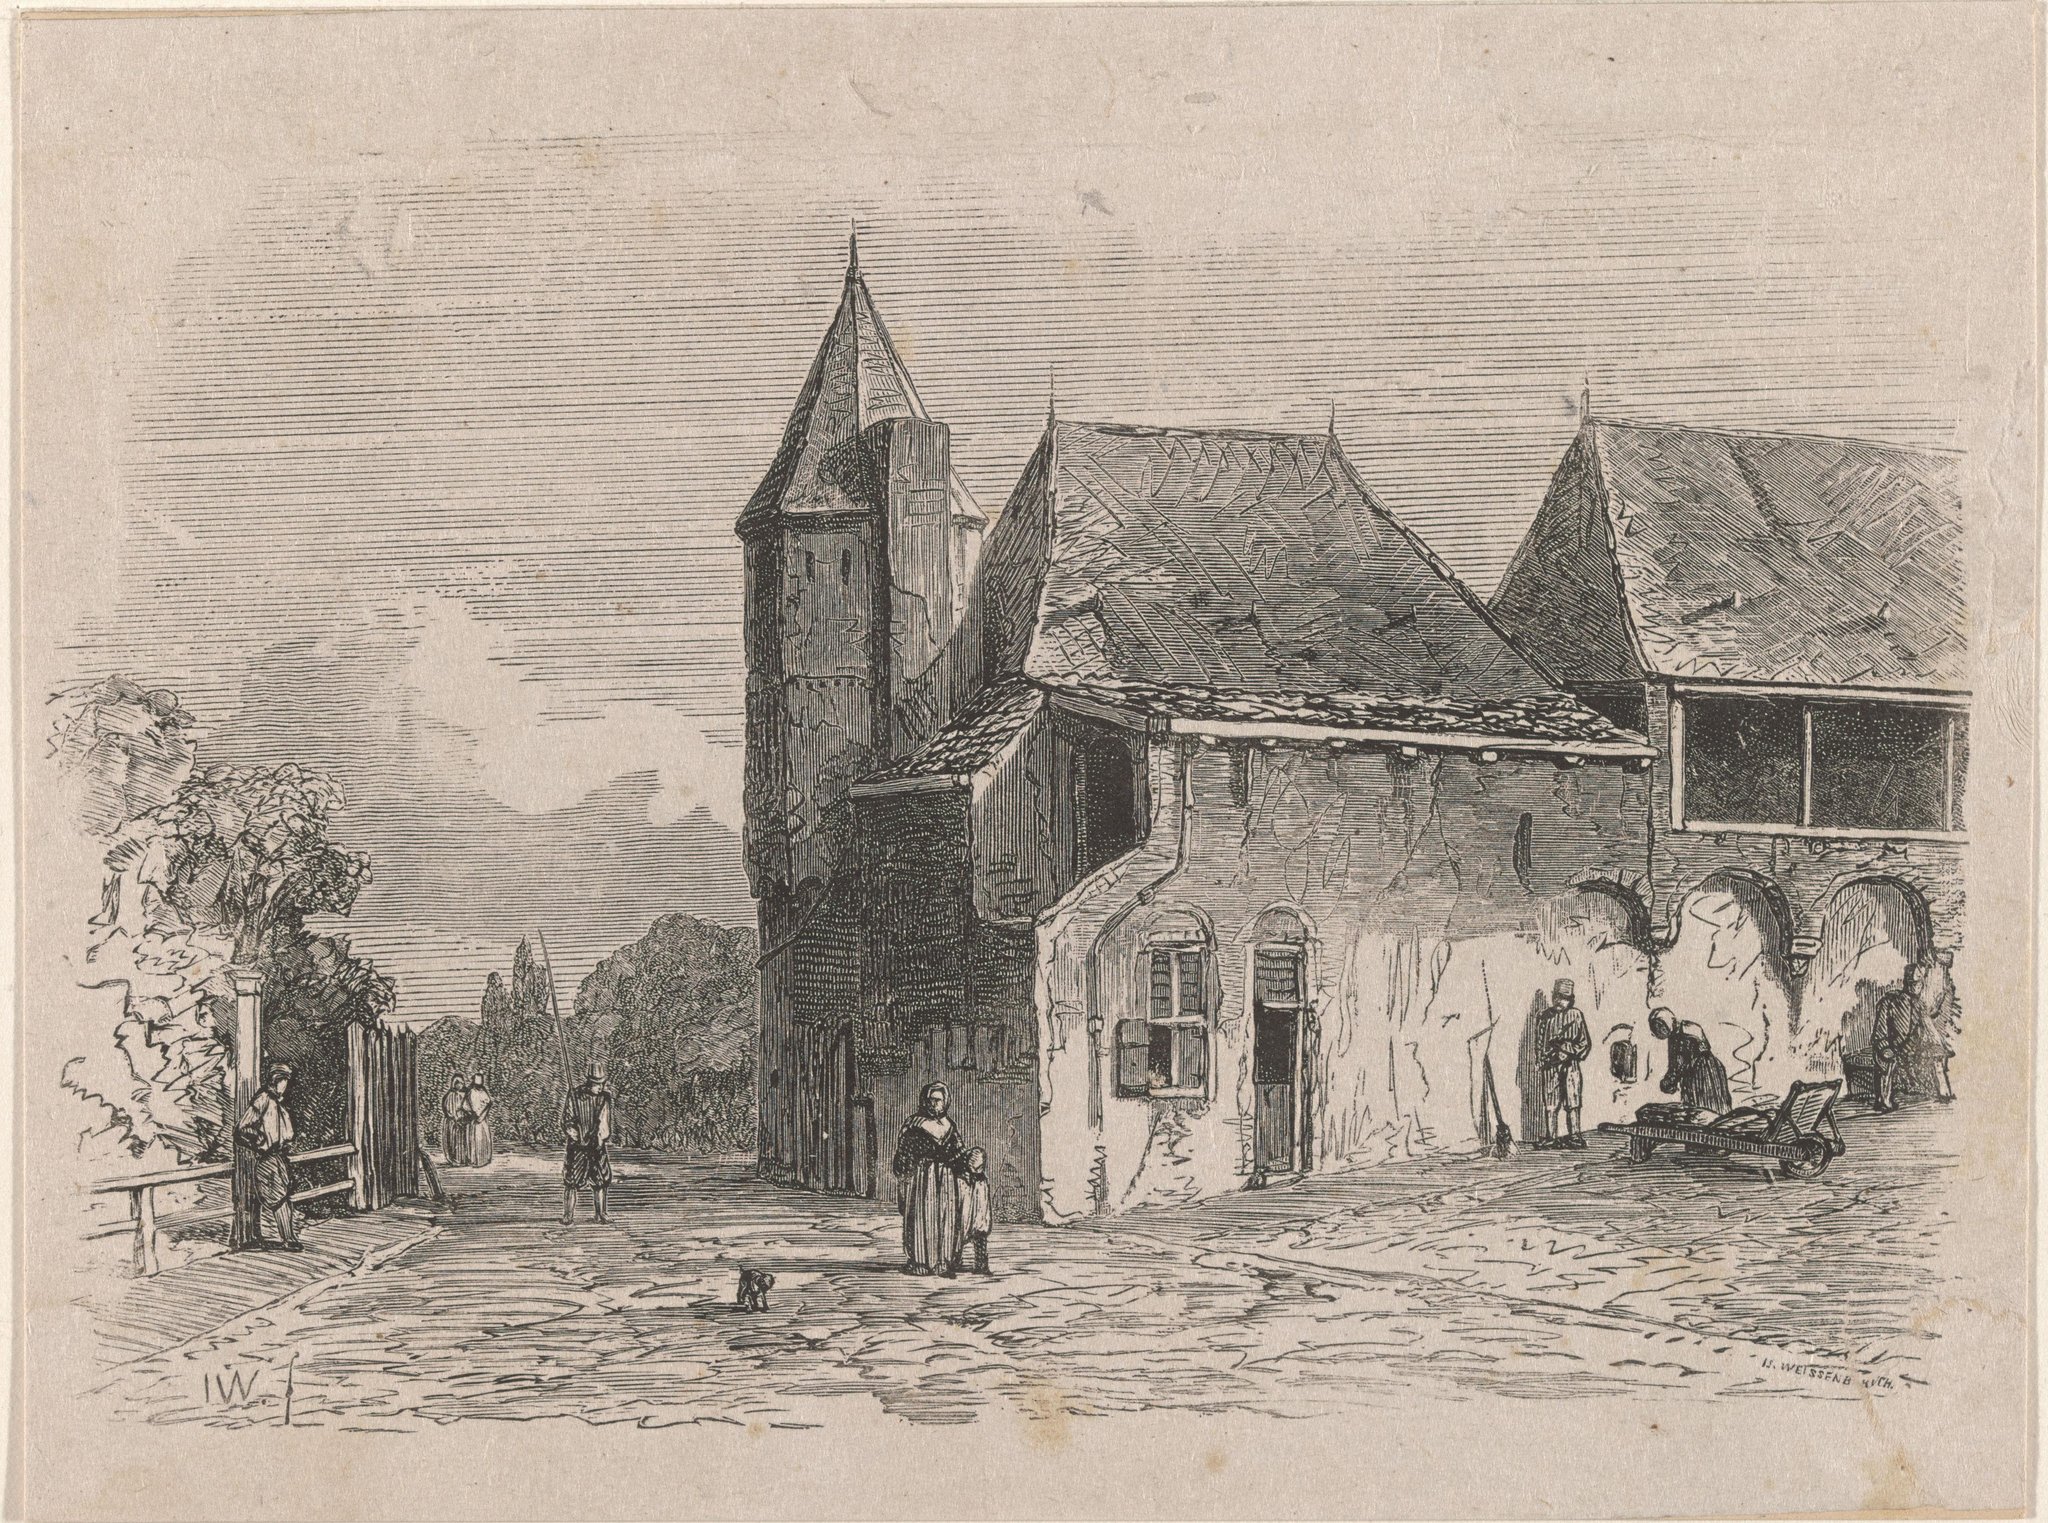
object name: print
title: Gezicht op de Koppelpoort te Amersfoort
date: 1836-1912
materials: paper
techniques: engraving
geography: netherlands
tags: civic architecture; edifices; dwellings, city-gate, tower (of house or building), street (+ city(-scape) with figures, staffage)